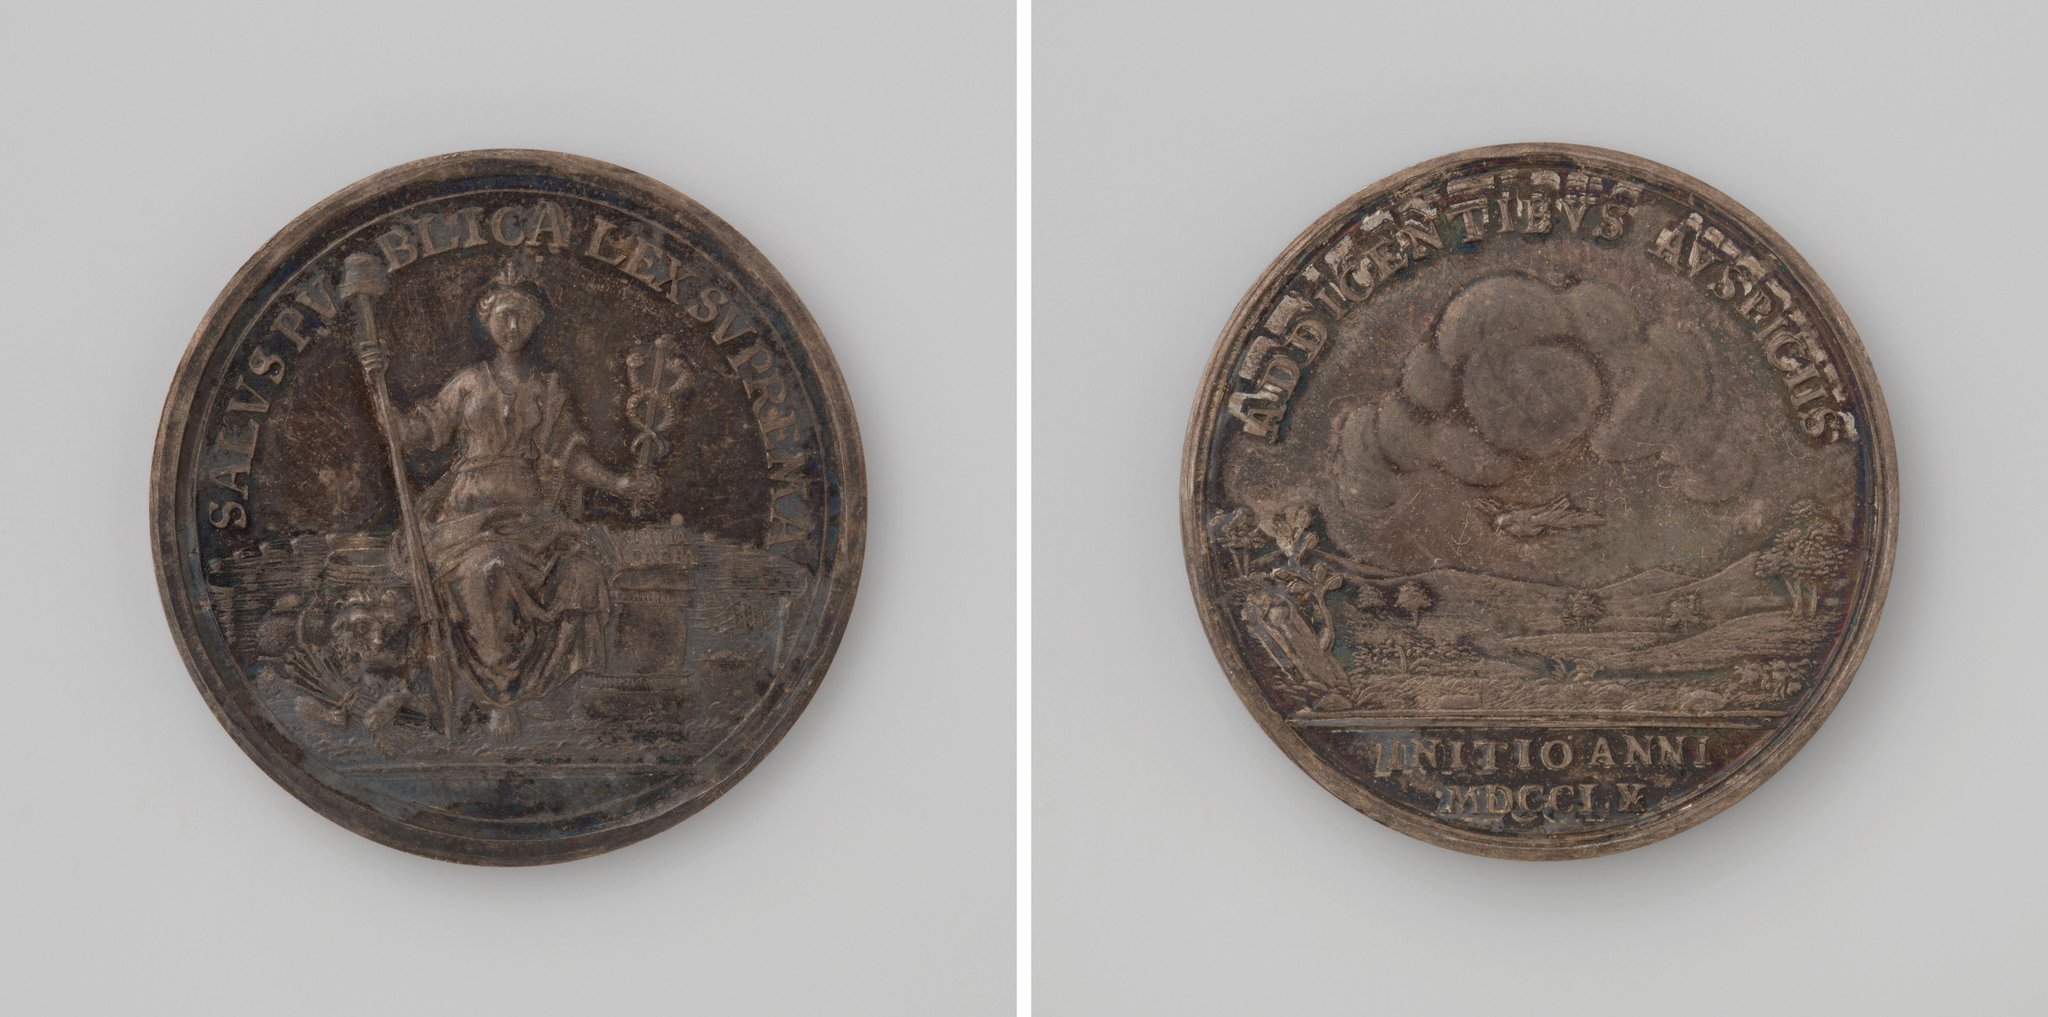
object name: new year medal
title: Aanvang van het jaar 1760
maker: johan george holtzhey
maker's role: mintmaster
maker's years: 1726-1808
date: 1760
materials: silver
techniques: striking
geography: amsterdam